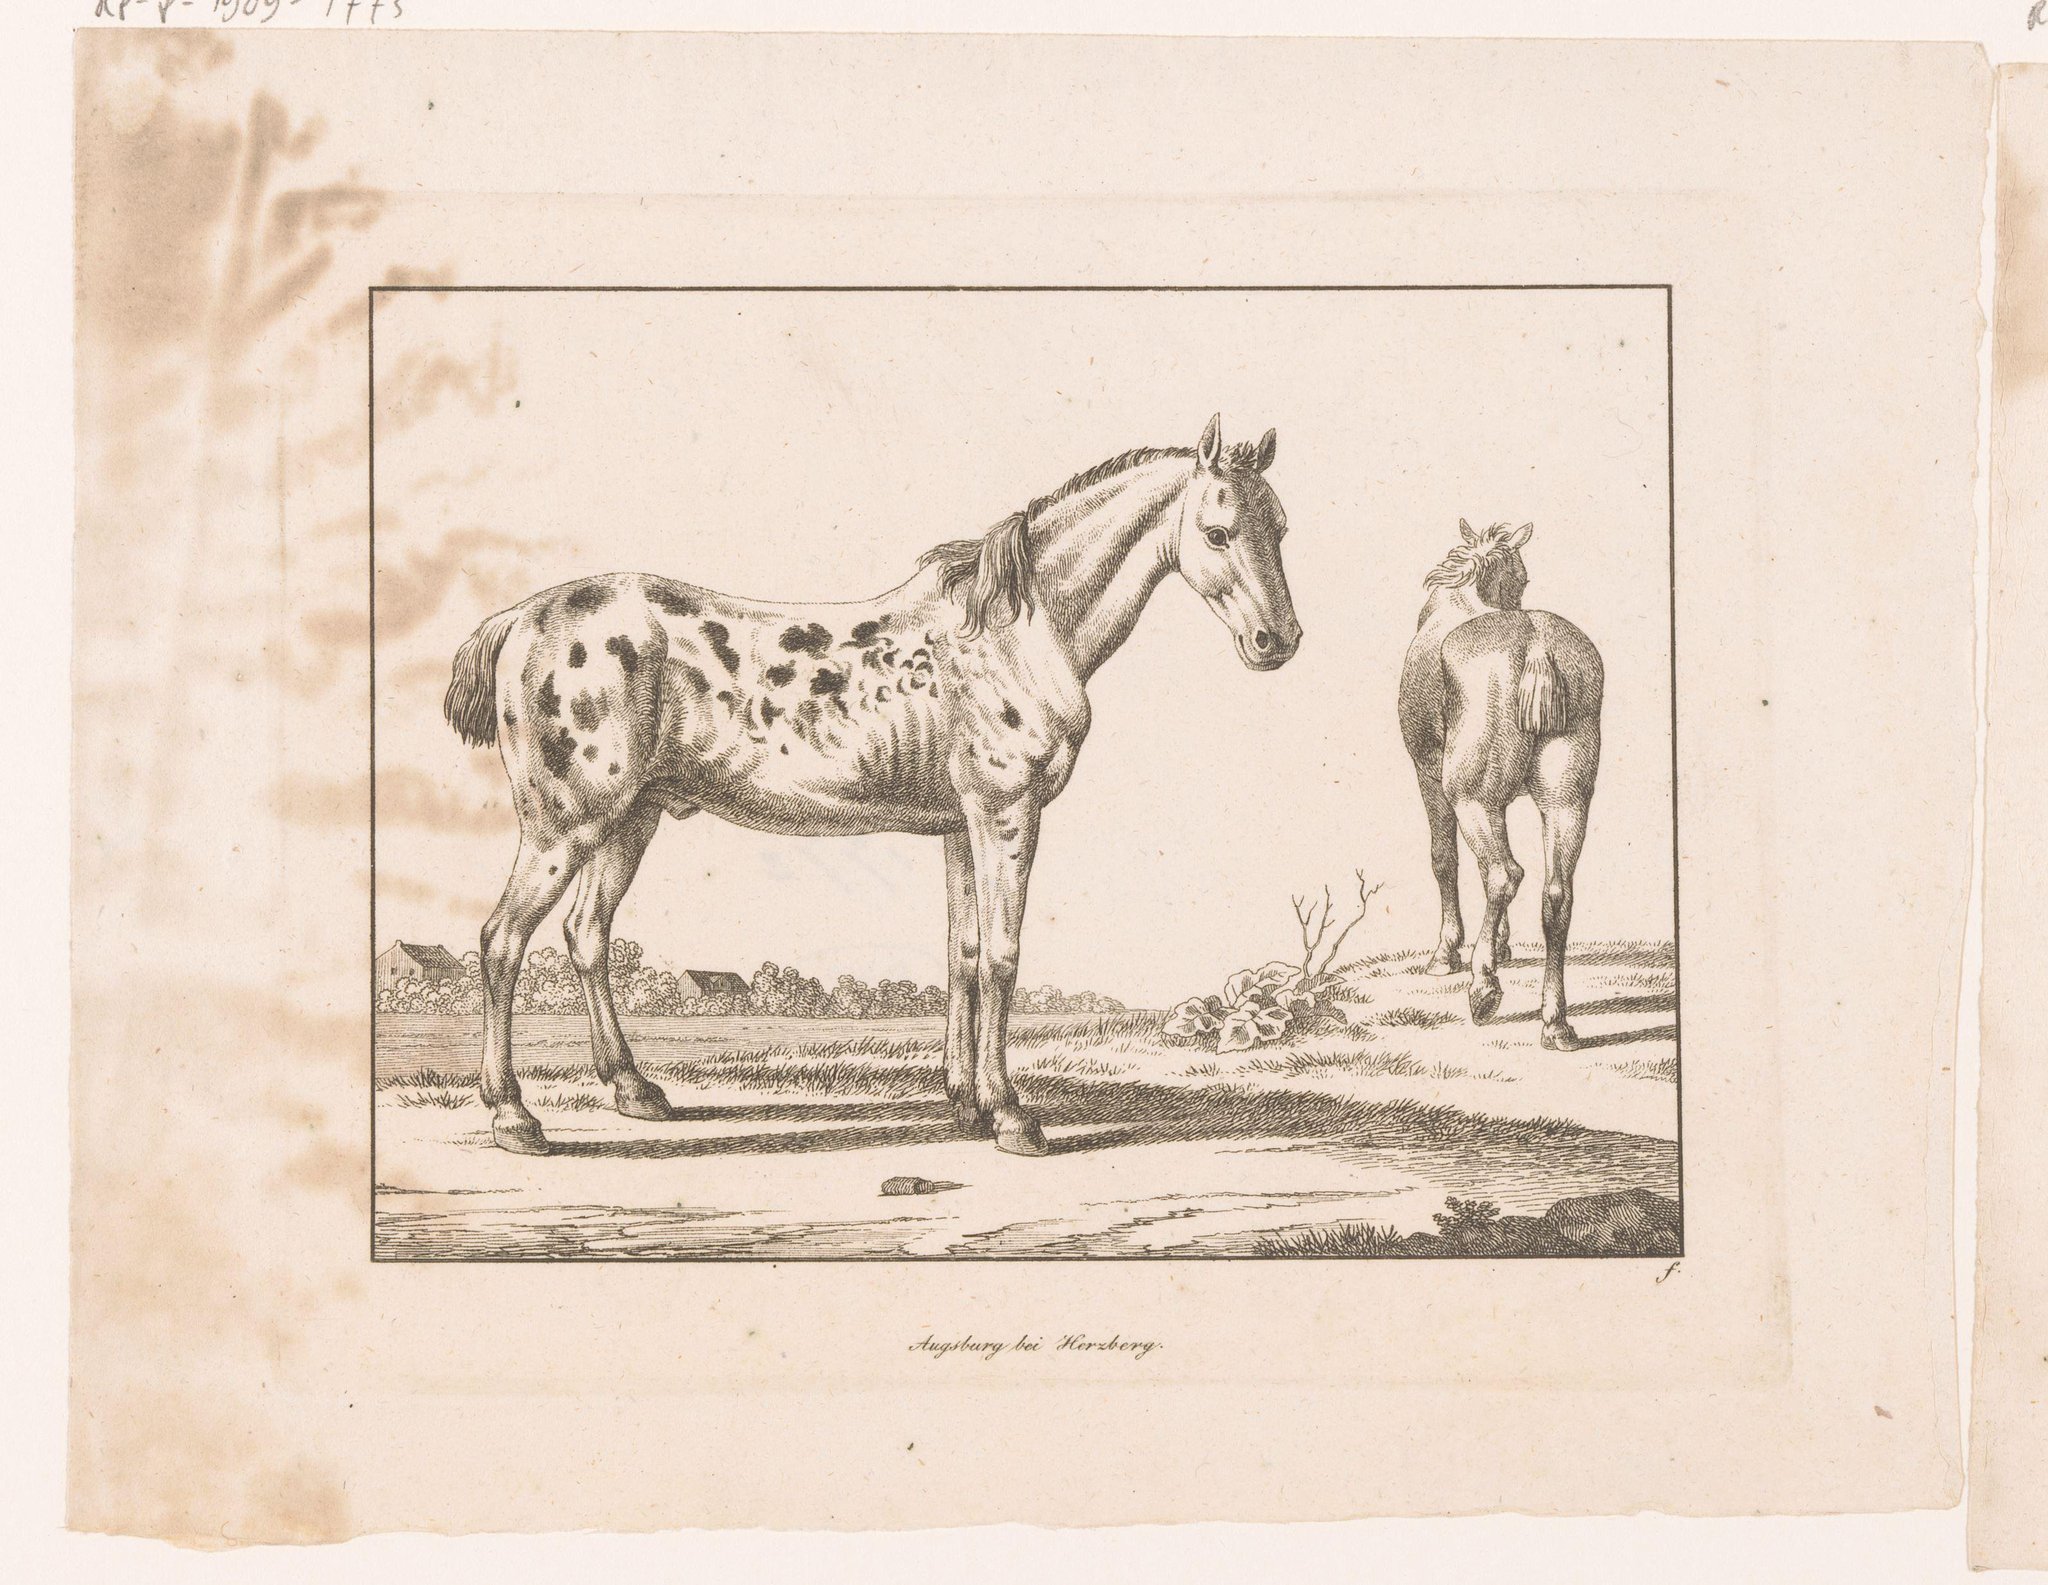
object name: print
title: Paard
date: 1750-1849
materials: paper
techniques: etching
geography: augsburg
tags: horse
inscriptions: collector's mark: Lugt 2228